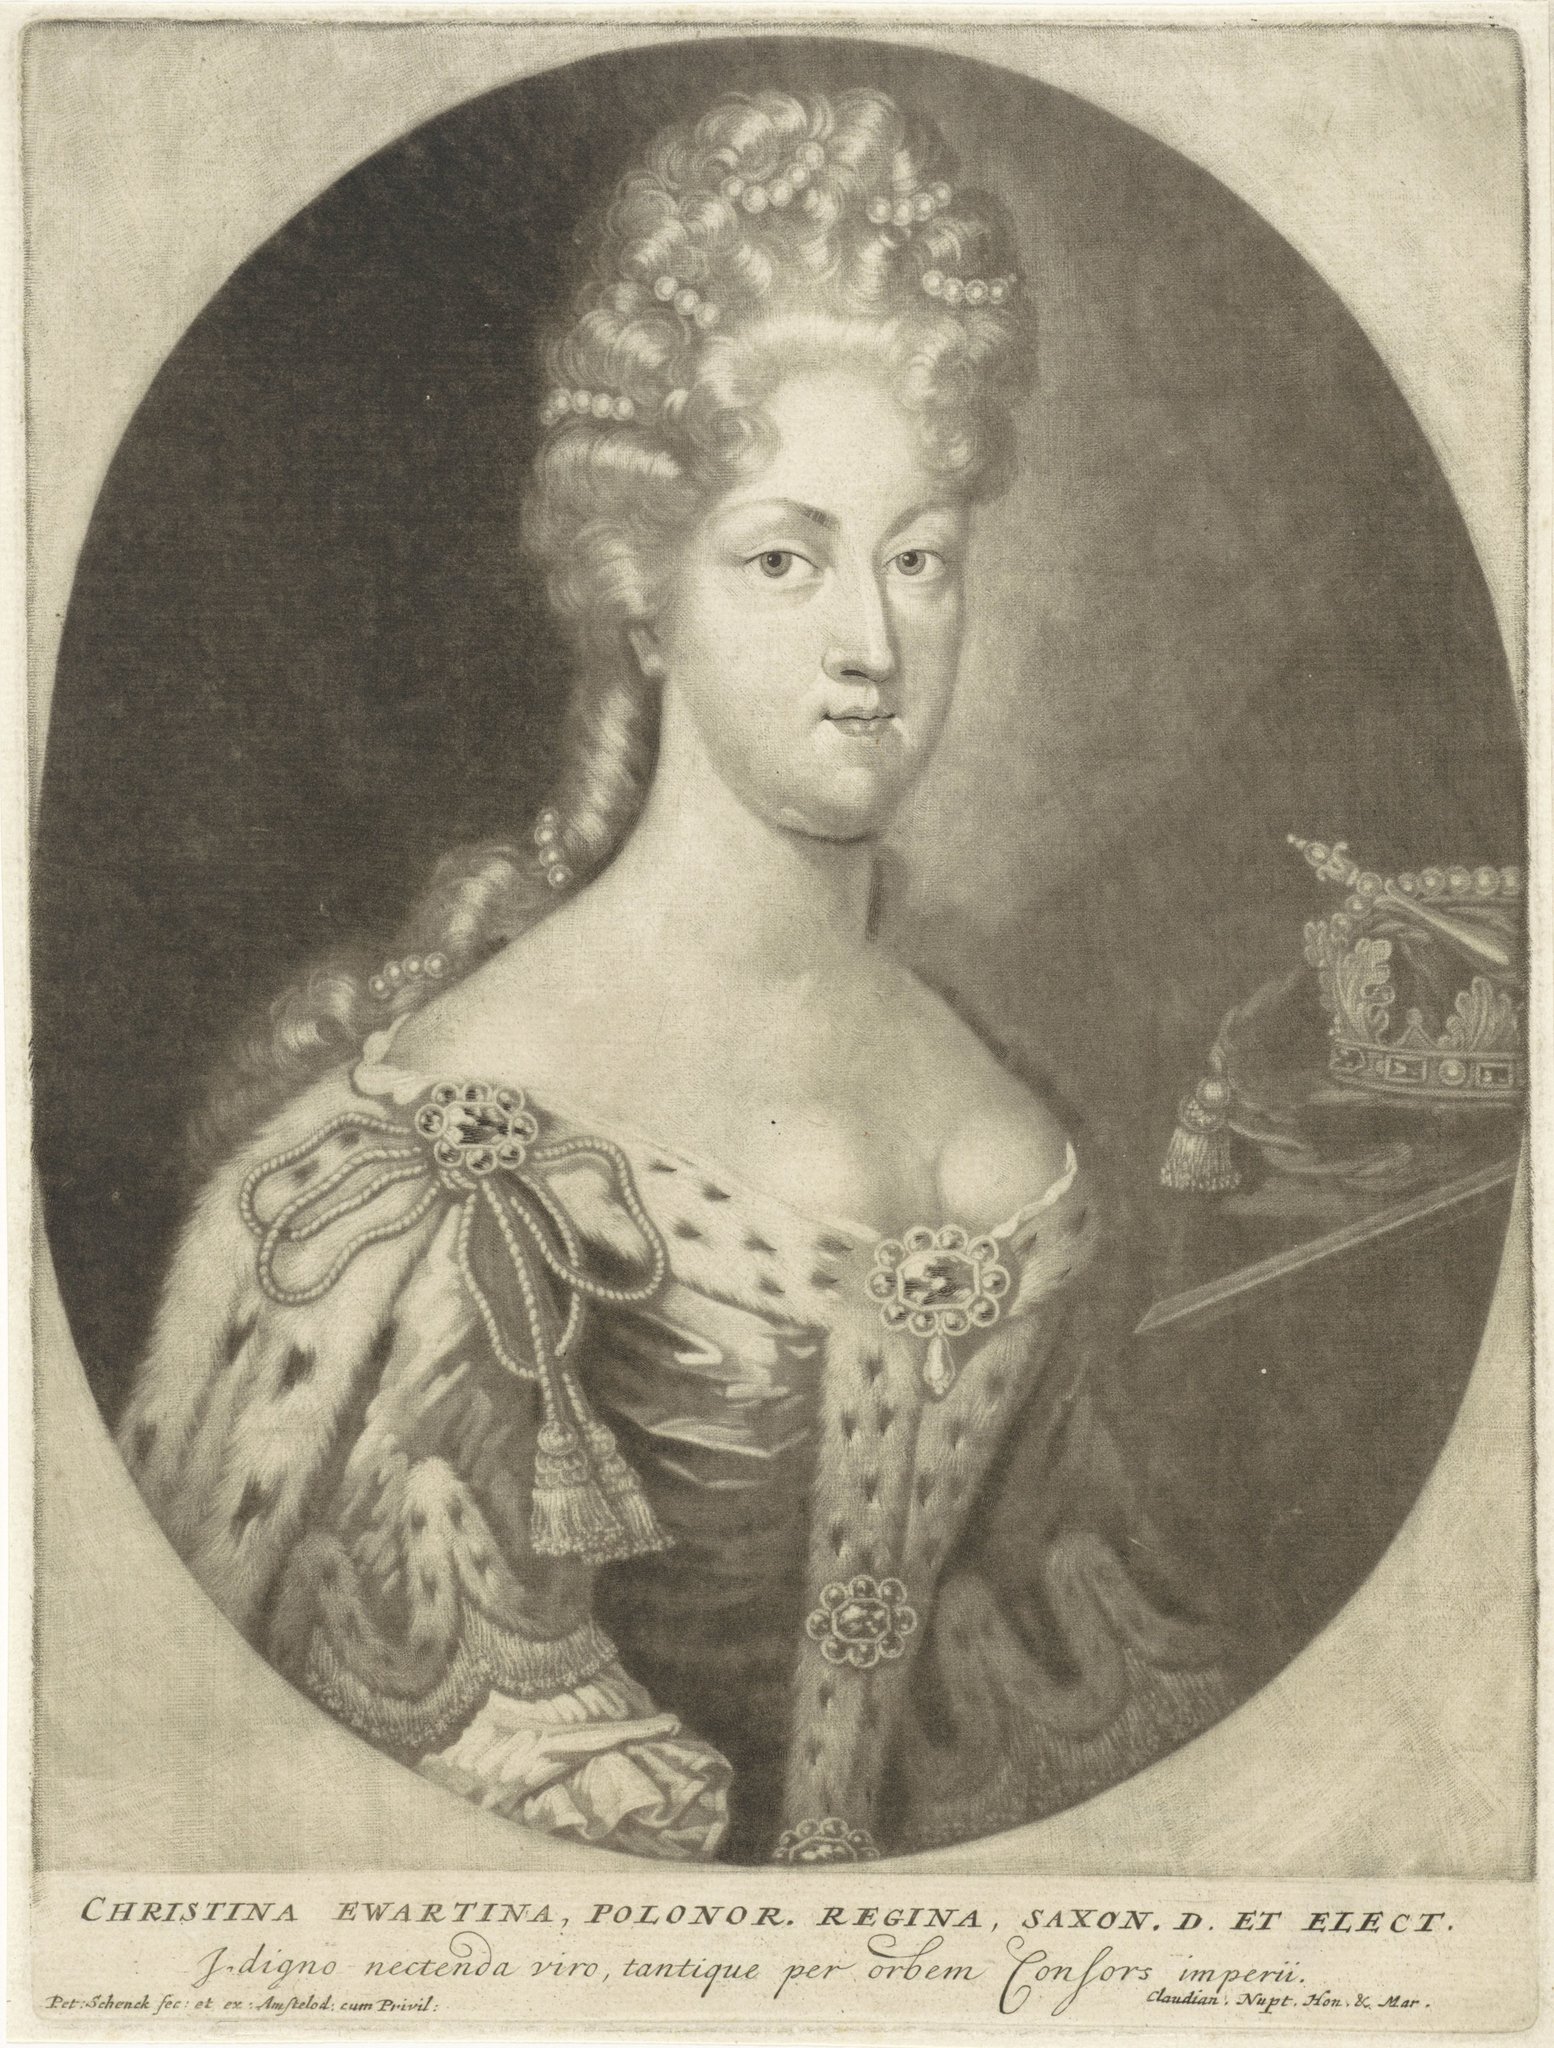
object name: print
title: Portret van Christina Ewartina van Saksen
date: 1670-1713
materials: paper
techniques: engraving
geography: amsterdam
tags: crown (symbol of sovereignty), pearl; pearl necklace (+ women's clothes)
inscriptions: collector's mark: Lugt 2228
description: Christina Ewartina, hertogin van Saksen met parelsnoeren in het haar. Naast haar de kroon.